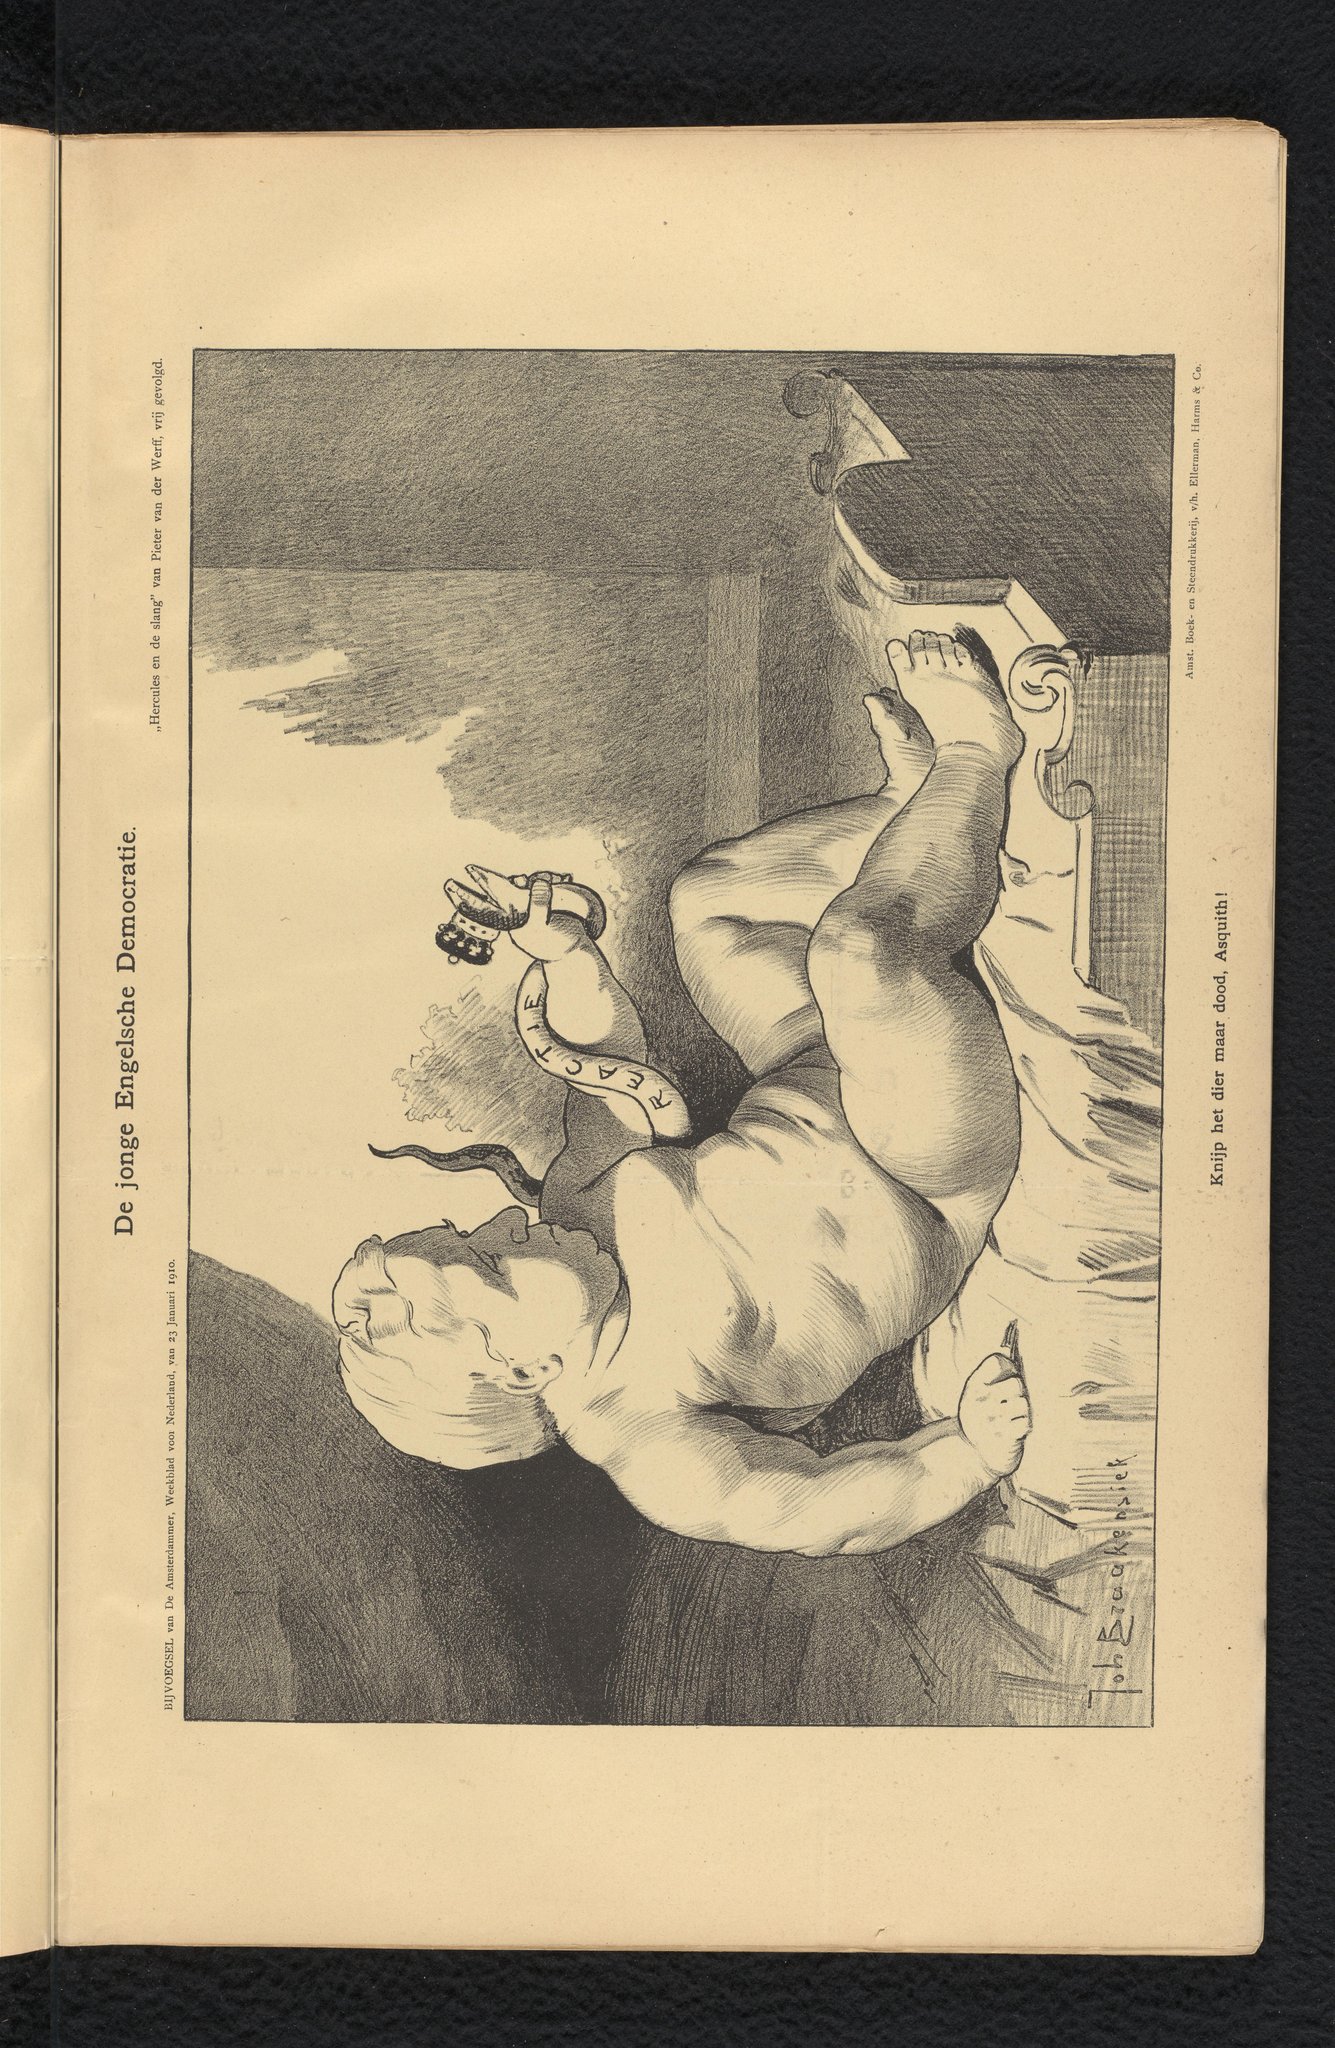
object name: cartoon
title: De jonge Engelsche Democratie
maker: johan braakensiek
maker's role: draughtsman, print maker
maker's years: 1858-1940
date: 1910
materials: paper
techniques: lithograph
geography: amsterdam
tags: hercules strangles two serpents in his cradle, political caricatures and satires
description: De Engelse premier Asquith die als Hercules in de wieg de gekroonde slang van 'reactie' doodknijpt.